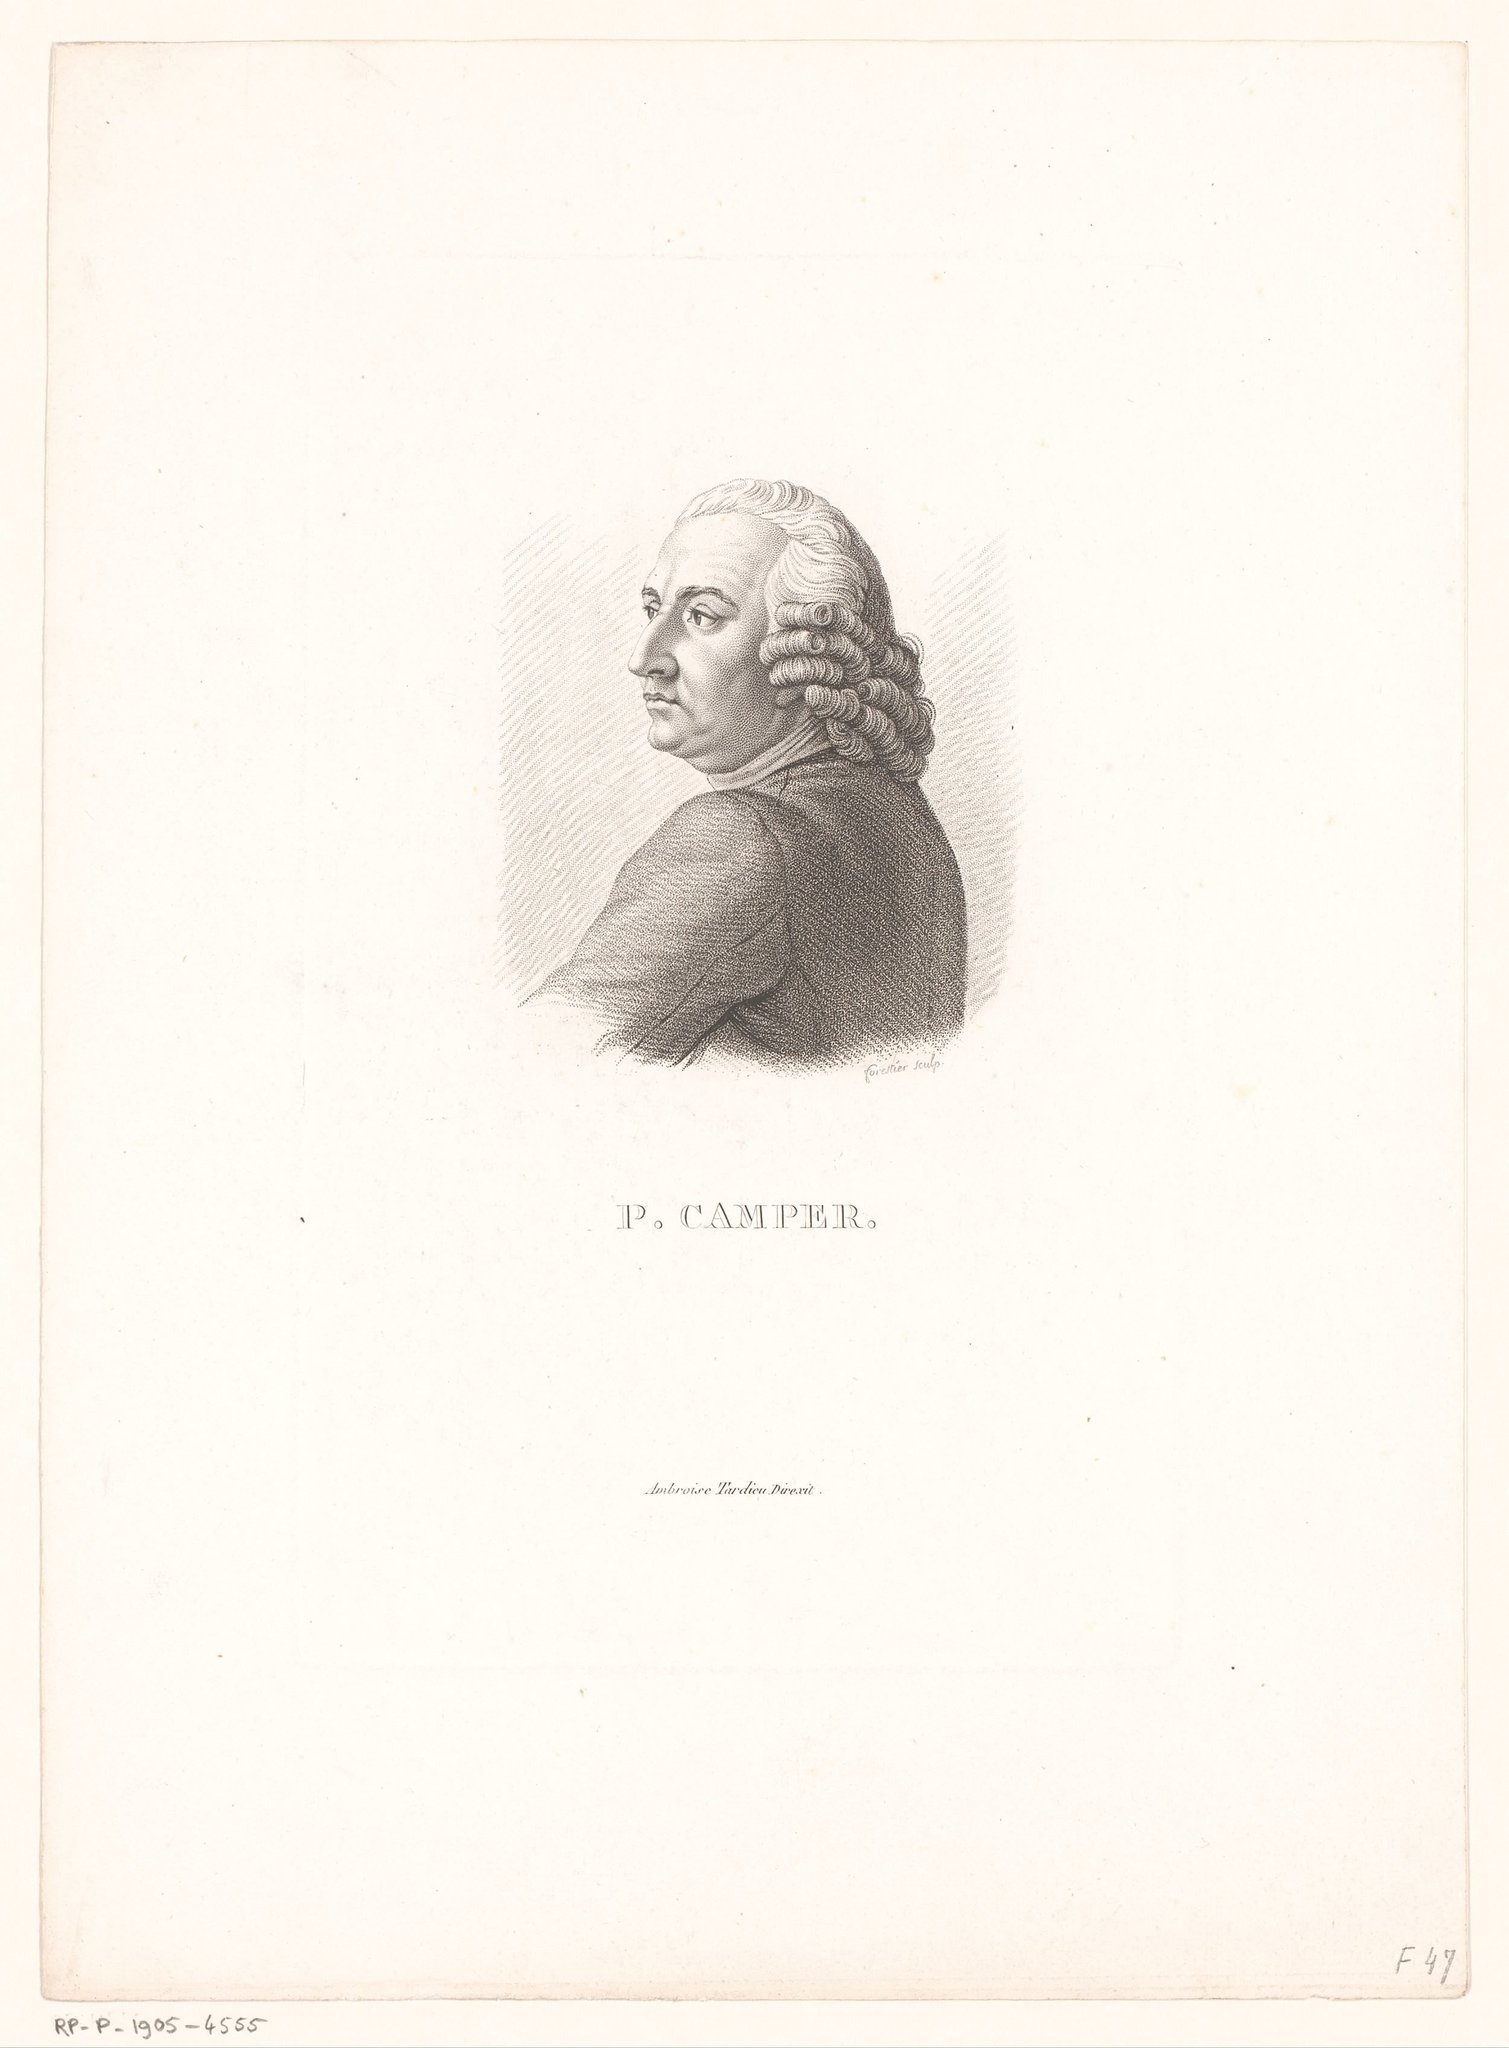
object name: print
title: Portret van Petrus Camper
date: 1818-1832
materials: paper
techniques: engraving, roulette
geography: paris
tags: leiden, the hague, print maker, draughtsman, petrus camper, historical persons, physician, doctor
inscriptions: collector's mark: Lugt 2228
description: Mogelijk prent uit: Journal complémentaire du Dictionnaire des sciences médicales. Parijs: Panckoucke, Charles Louis Fleury, 1818-1832.